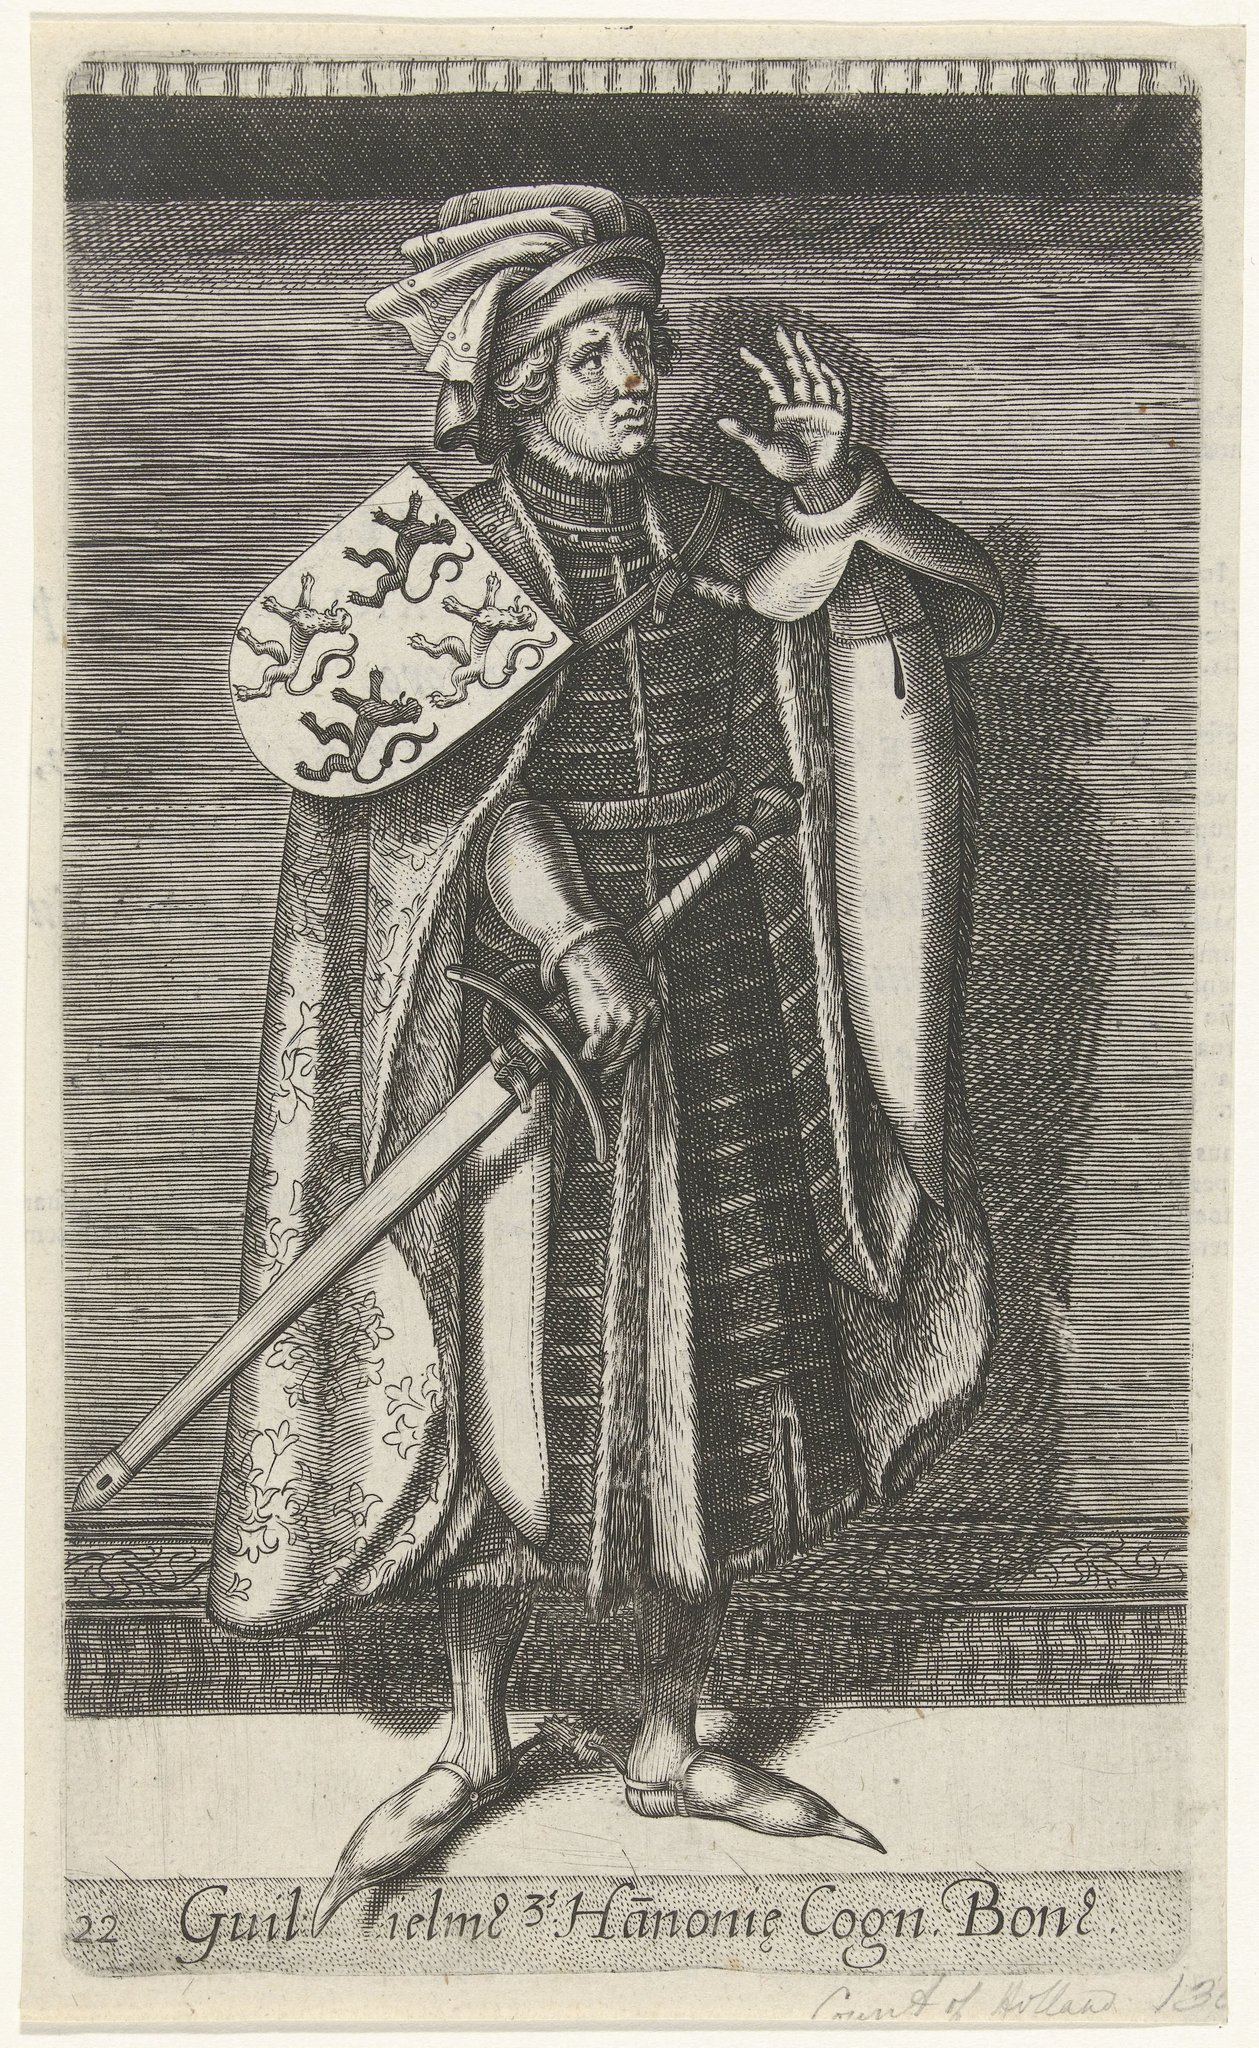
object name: book illustration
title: Portret van Willem III de Goede, graaf van Holland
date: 1578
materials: paper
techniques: engraving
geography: haarlem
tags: willem iii de goede (graaf van holland en henegouwen)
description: Willem III de goede, graaf van Holland en Henegouwen. Staande, ten voeten uit. Hij draagt een zwaard in zijn rechterhand. Op zijn linkerschouder het wapenschild van Holland en Henegouwen. De prent dient als een illustratie bij een boek over de geschiedenis van de graven van Holland.